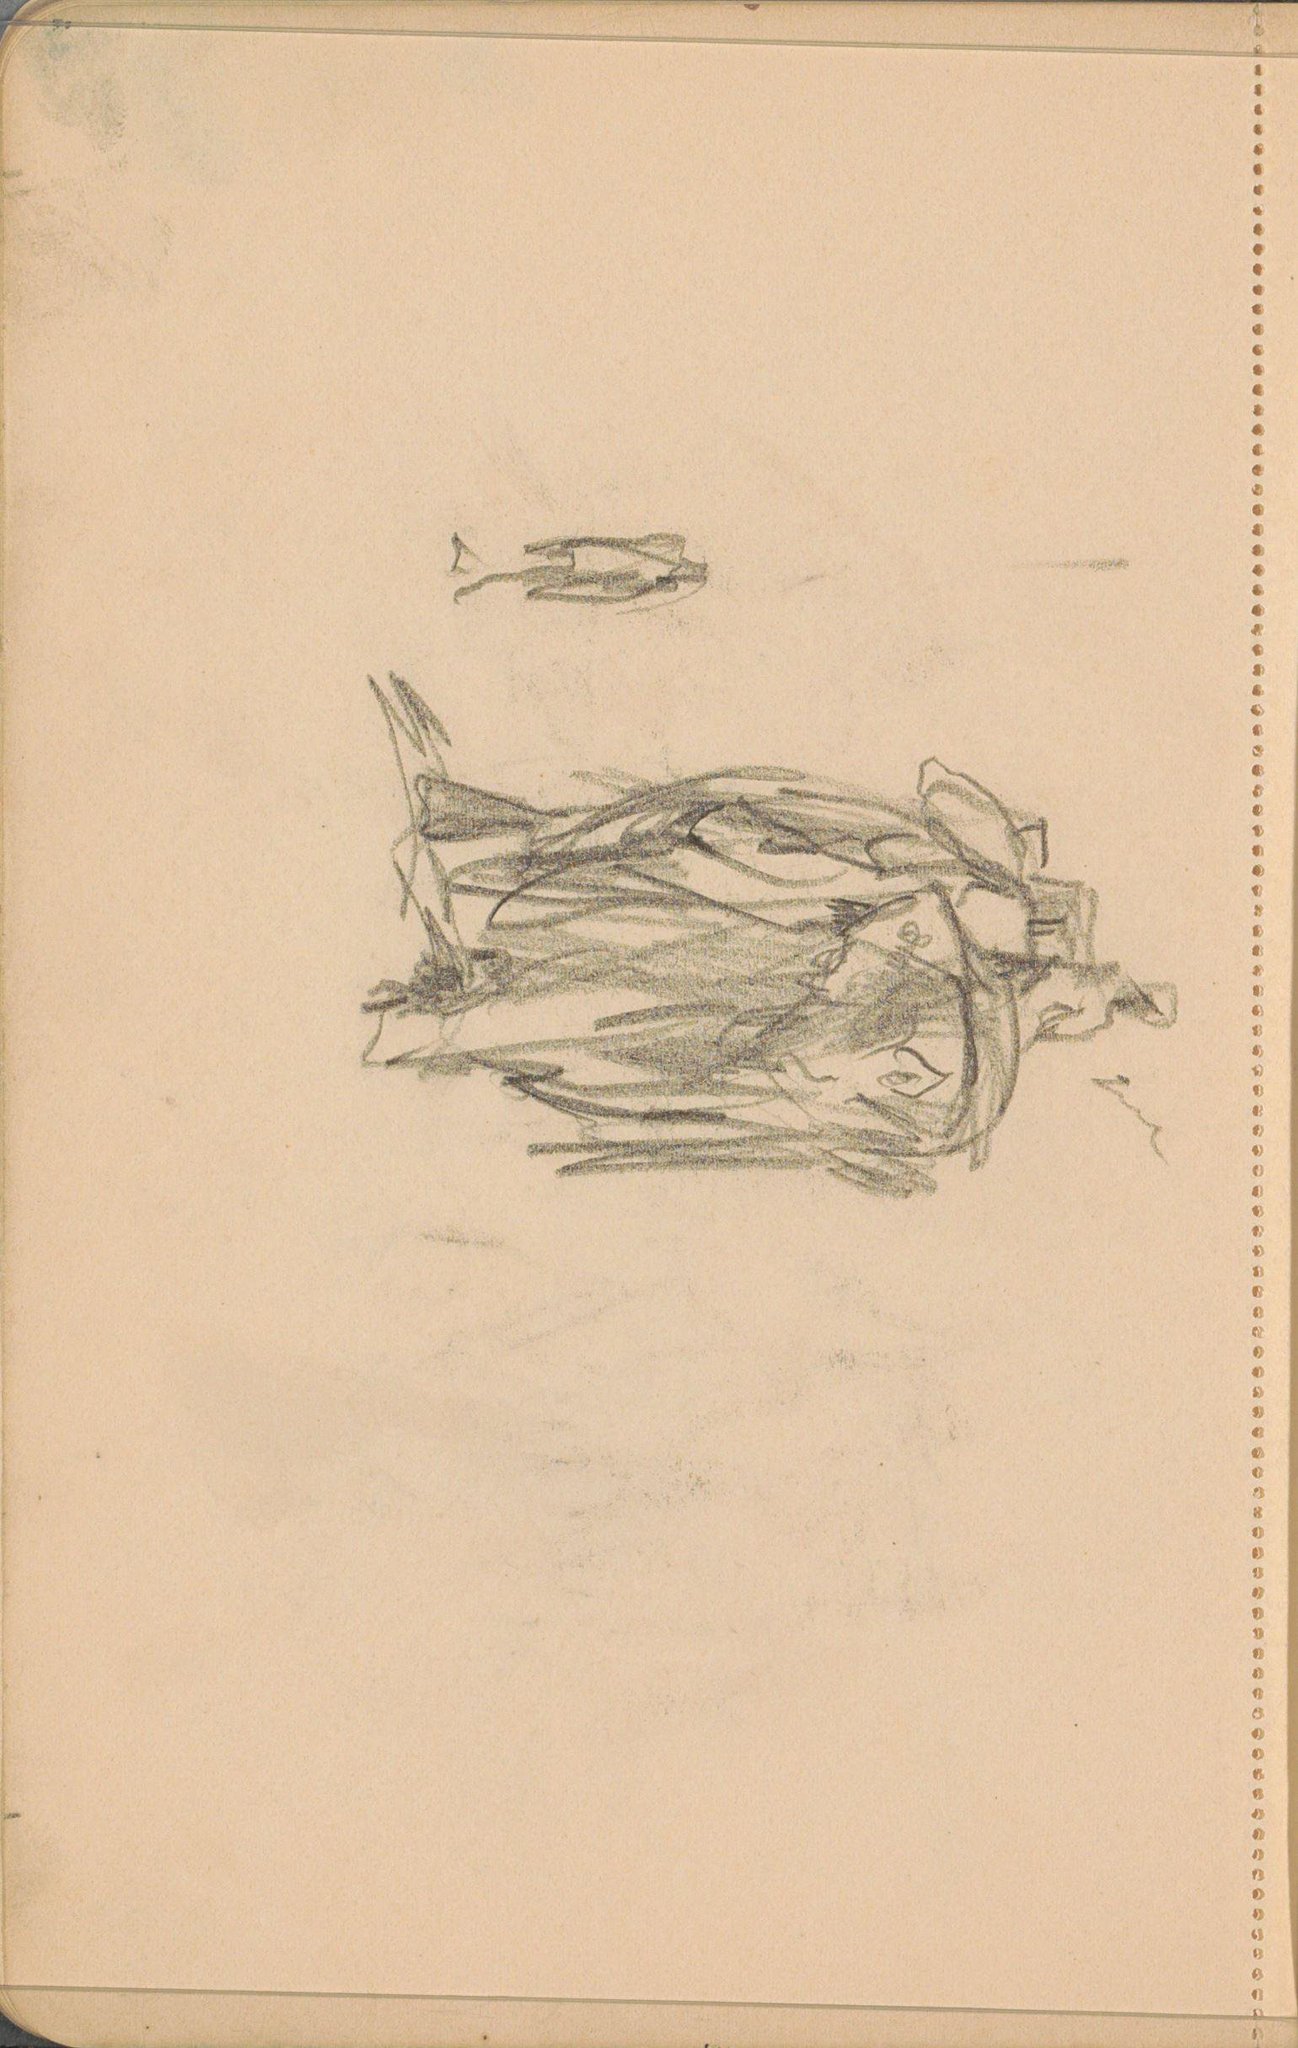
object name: sketchbook leaf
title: Figuur op een olifant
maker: marius bauer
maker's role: draughtsman, print maker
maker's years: 1867-1932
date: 1924-1925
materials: paper, pencil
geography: india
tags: sitting figure, trunked animals: elephant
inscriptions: kleurnotitie, handgeschreven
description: Pagina 50 uit een schetsboek met 87 bladen.